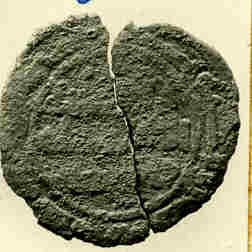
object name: coin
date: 718-814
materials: copper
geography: iran